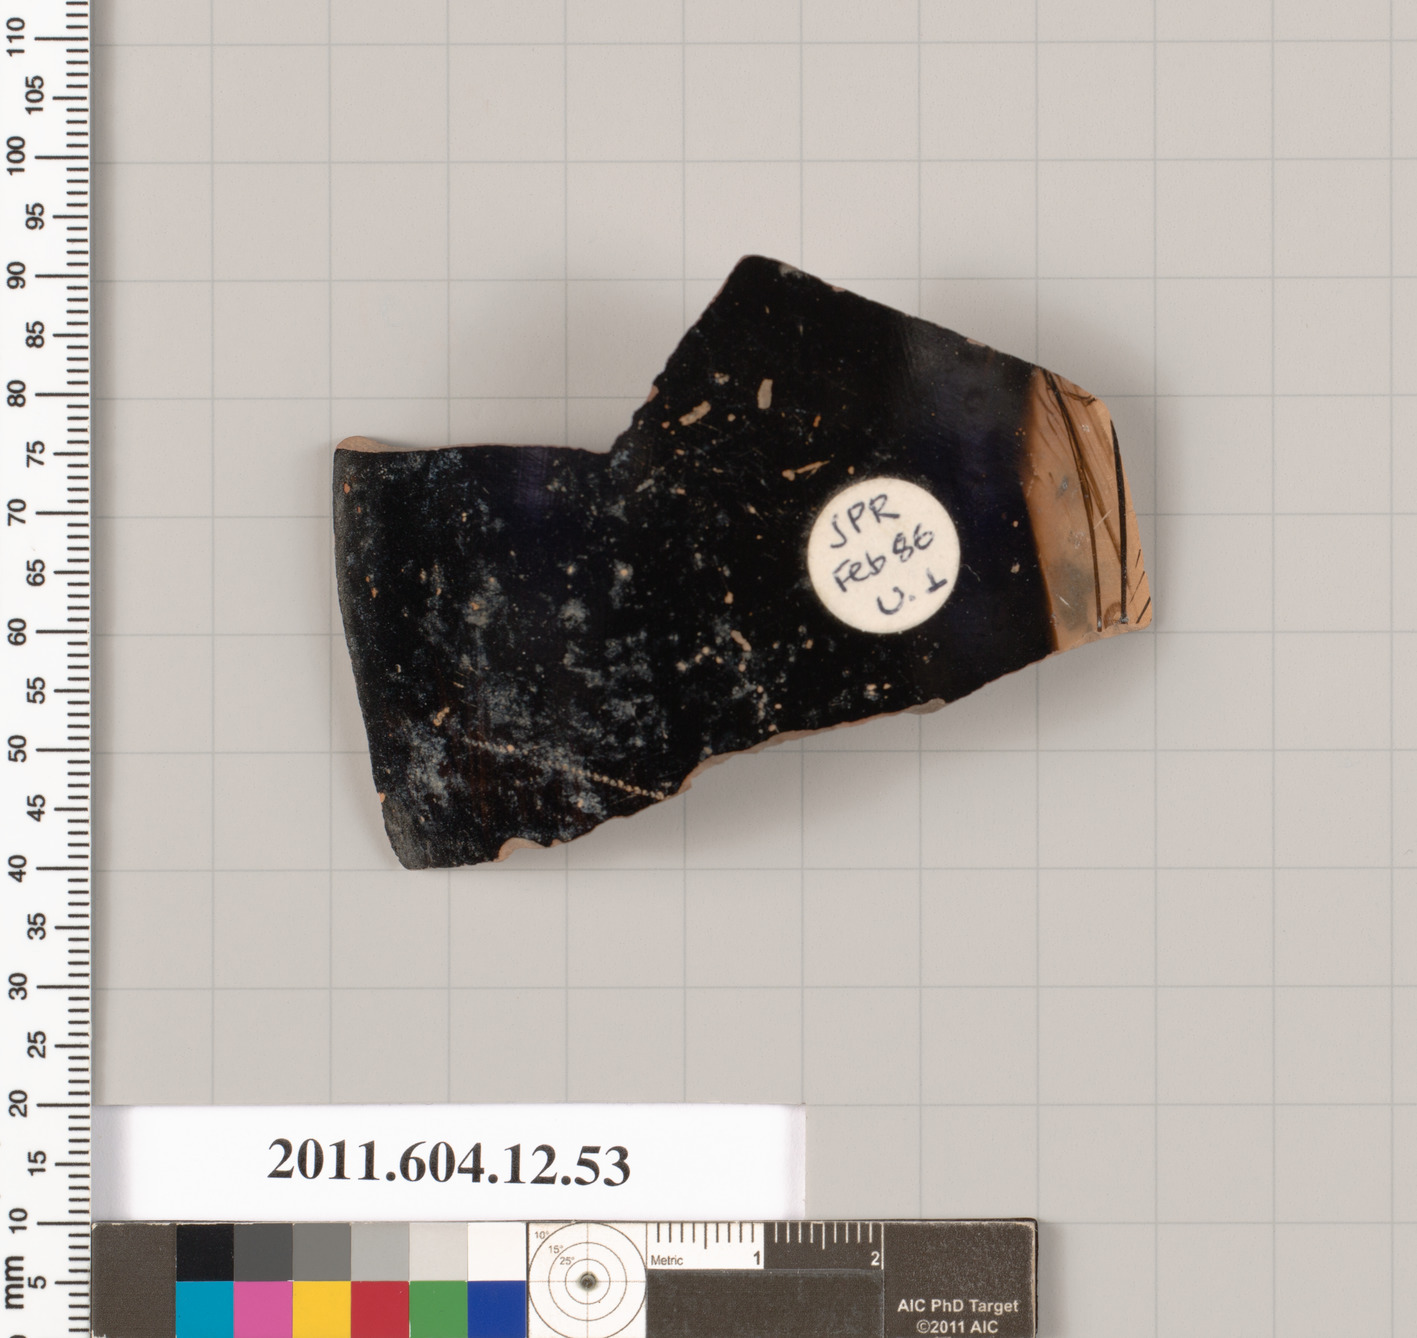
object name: squat lekythos fragment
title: Terracotta fragment of a squat lekythos (oil flask)?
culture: greek or south italian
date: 400-301 BCE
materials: terracotta